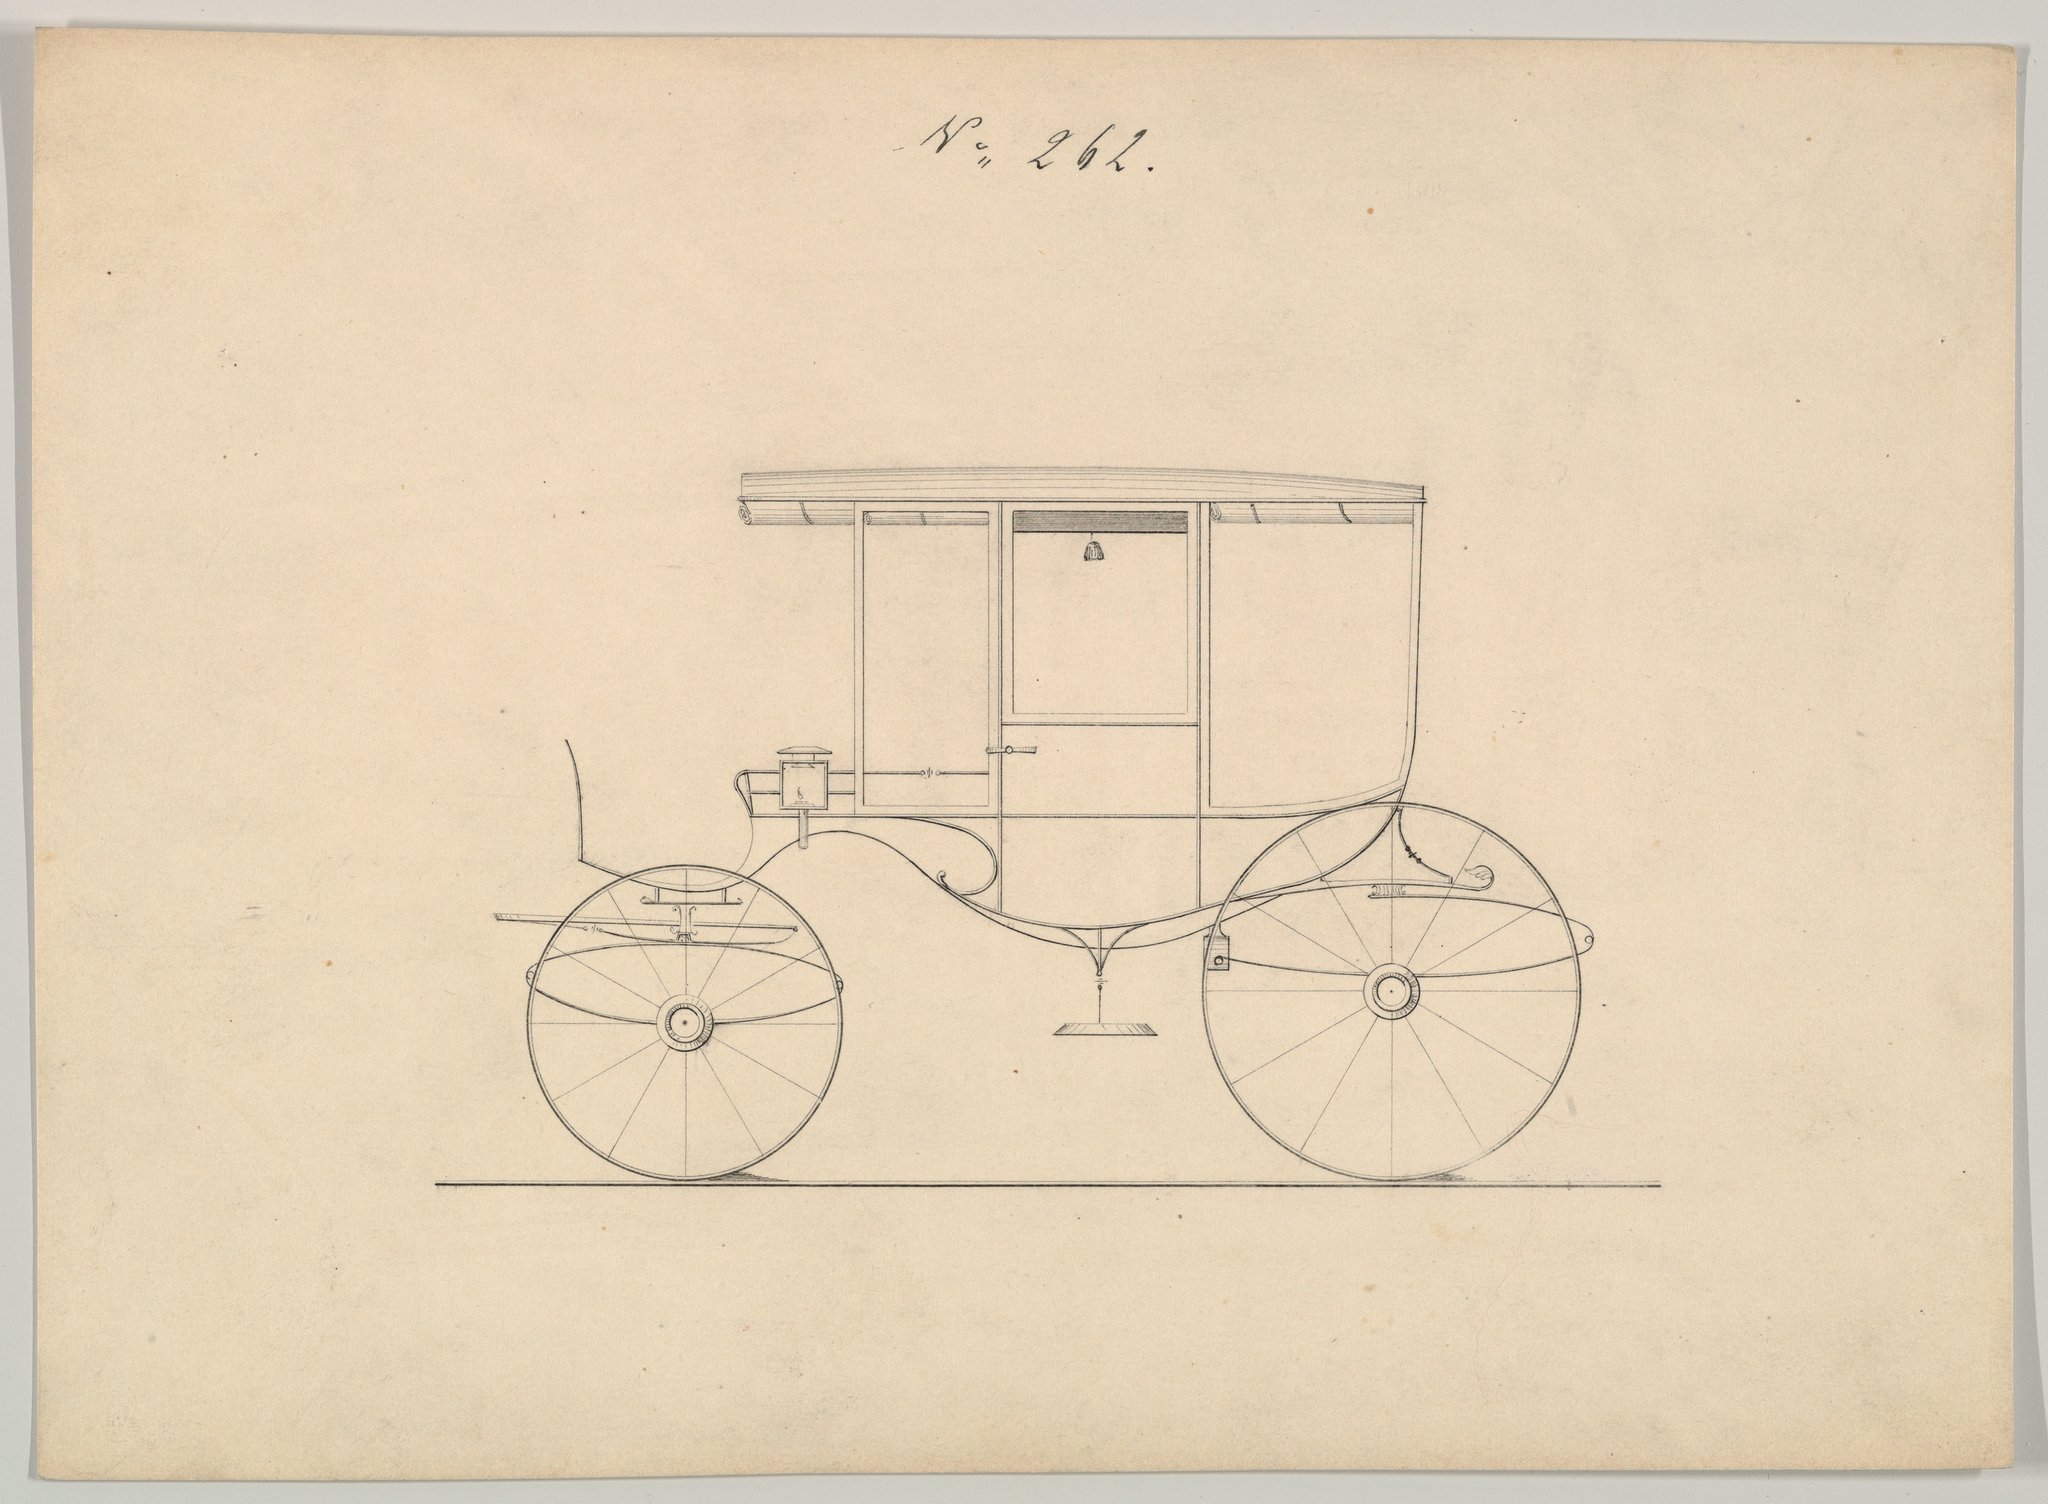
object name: drawing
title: Rockaway #262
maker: brewster & co.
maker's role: manufacturer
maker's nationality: american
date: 1860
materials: ink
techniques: pen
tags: carriages